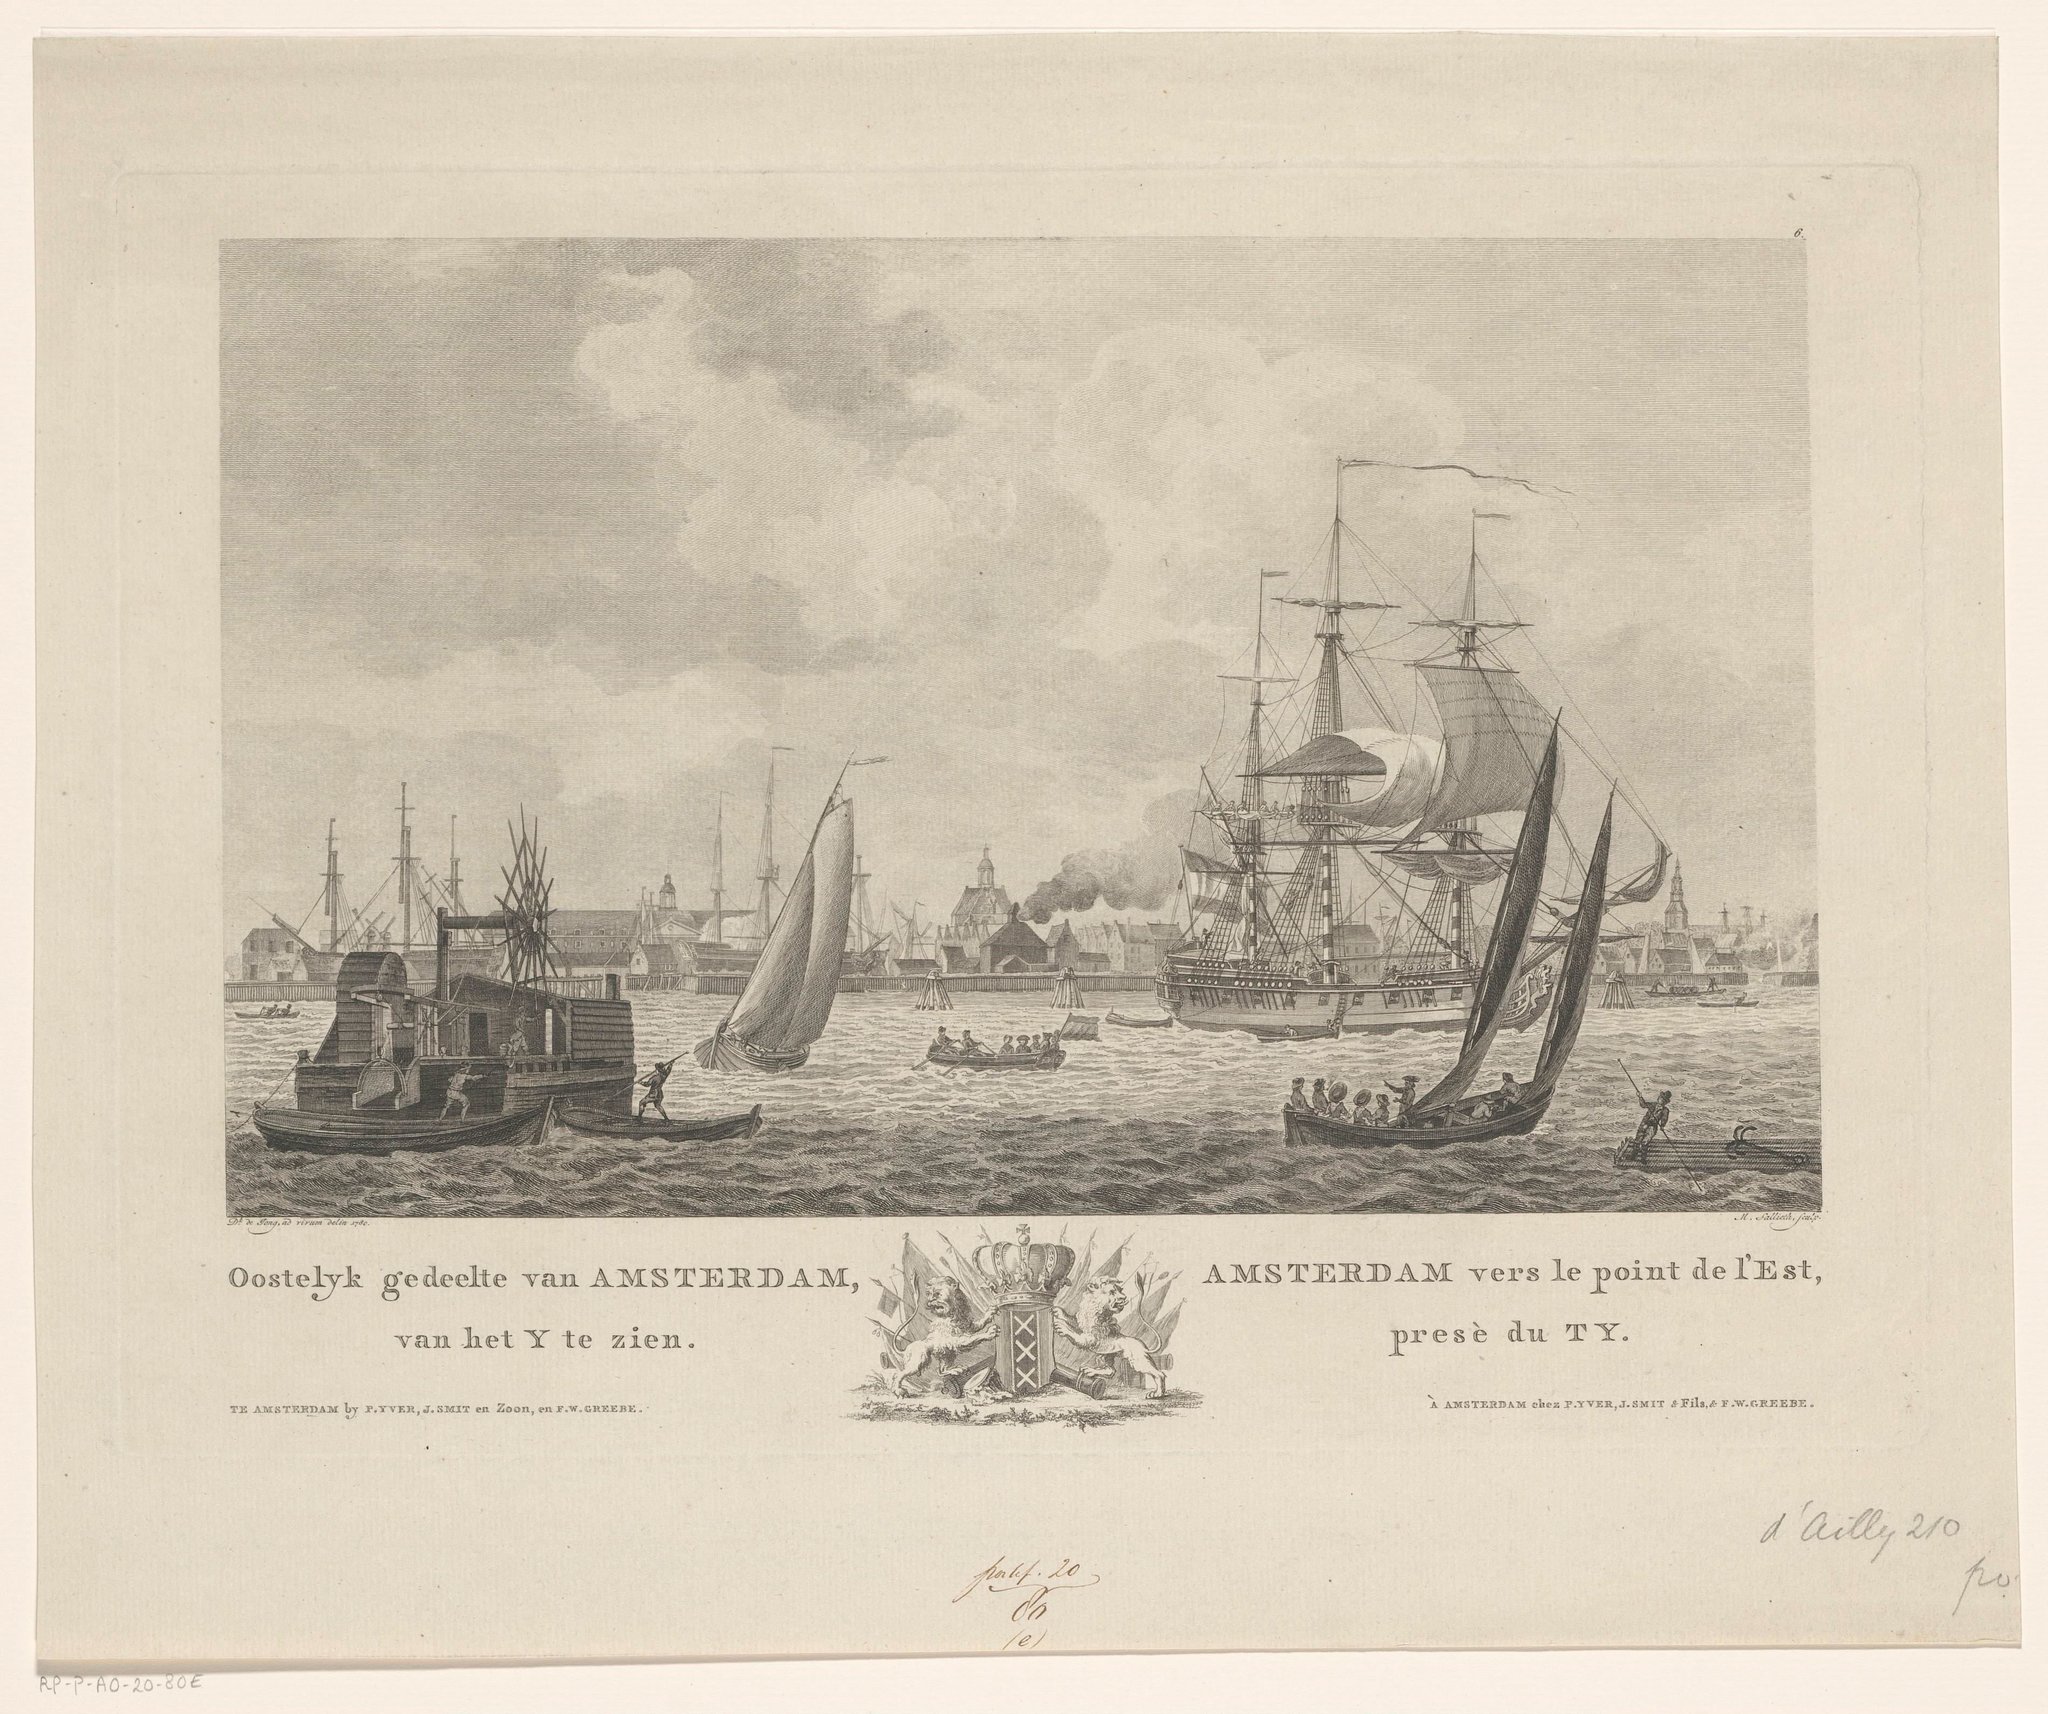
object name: print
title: Oostelyk gedeelte van Amsterdam, van het Y te zien / Amsterdam vers le point de l'Est, presè du TY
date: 1780-1787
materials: paper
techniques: engraving, etching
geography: amsterdam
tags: coat of arms (as symbol of the state, etc.) (+ city; municipal), sailing-ship, sailing-boat, rowing-boat, canoe, etc., prospect of city, town panorama, silhouette of city, amsterdam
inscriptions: collector's mark: Lugt 2228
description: Latere staat van prent (RP-P-1905-882) ook gebruikt in: Aa, Cornelis van der. Atlas van de zeehavens der Bataafsche Republiek. Met derzelver beschrijvingen in XXXI kunstplaaten / Atlas van de zeehavens der Bataafsche Republiek, die van Batavia en Onrust. Mitsgaders de afbeeldingen van de haringvisscherij en de walvischvangst (…). Amsterdam: Evert Maaskamp, 1805. En in: Nieuwe atlas, van de voornaamste gebouwen en gezigten der stad Amsterdam. Met derzelver beknopte beschryvingen. Amsterdam: Evert Maaskamp, 1805.